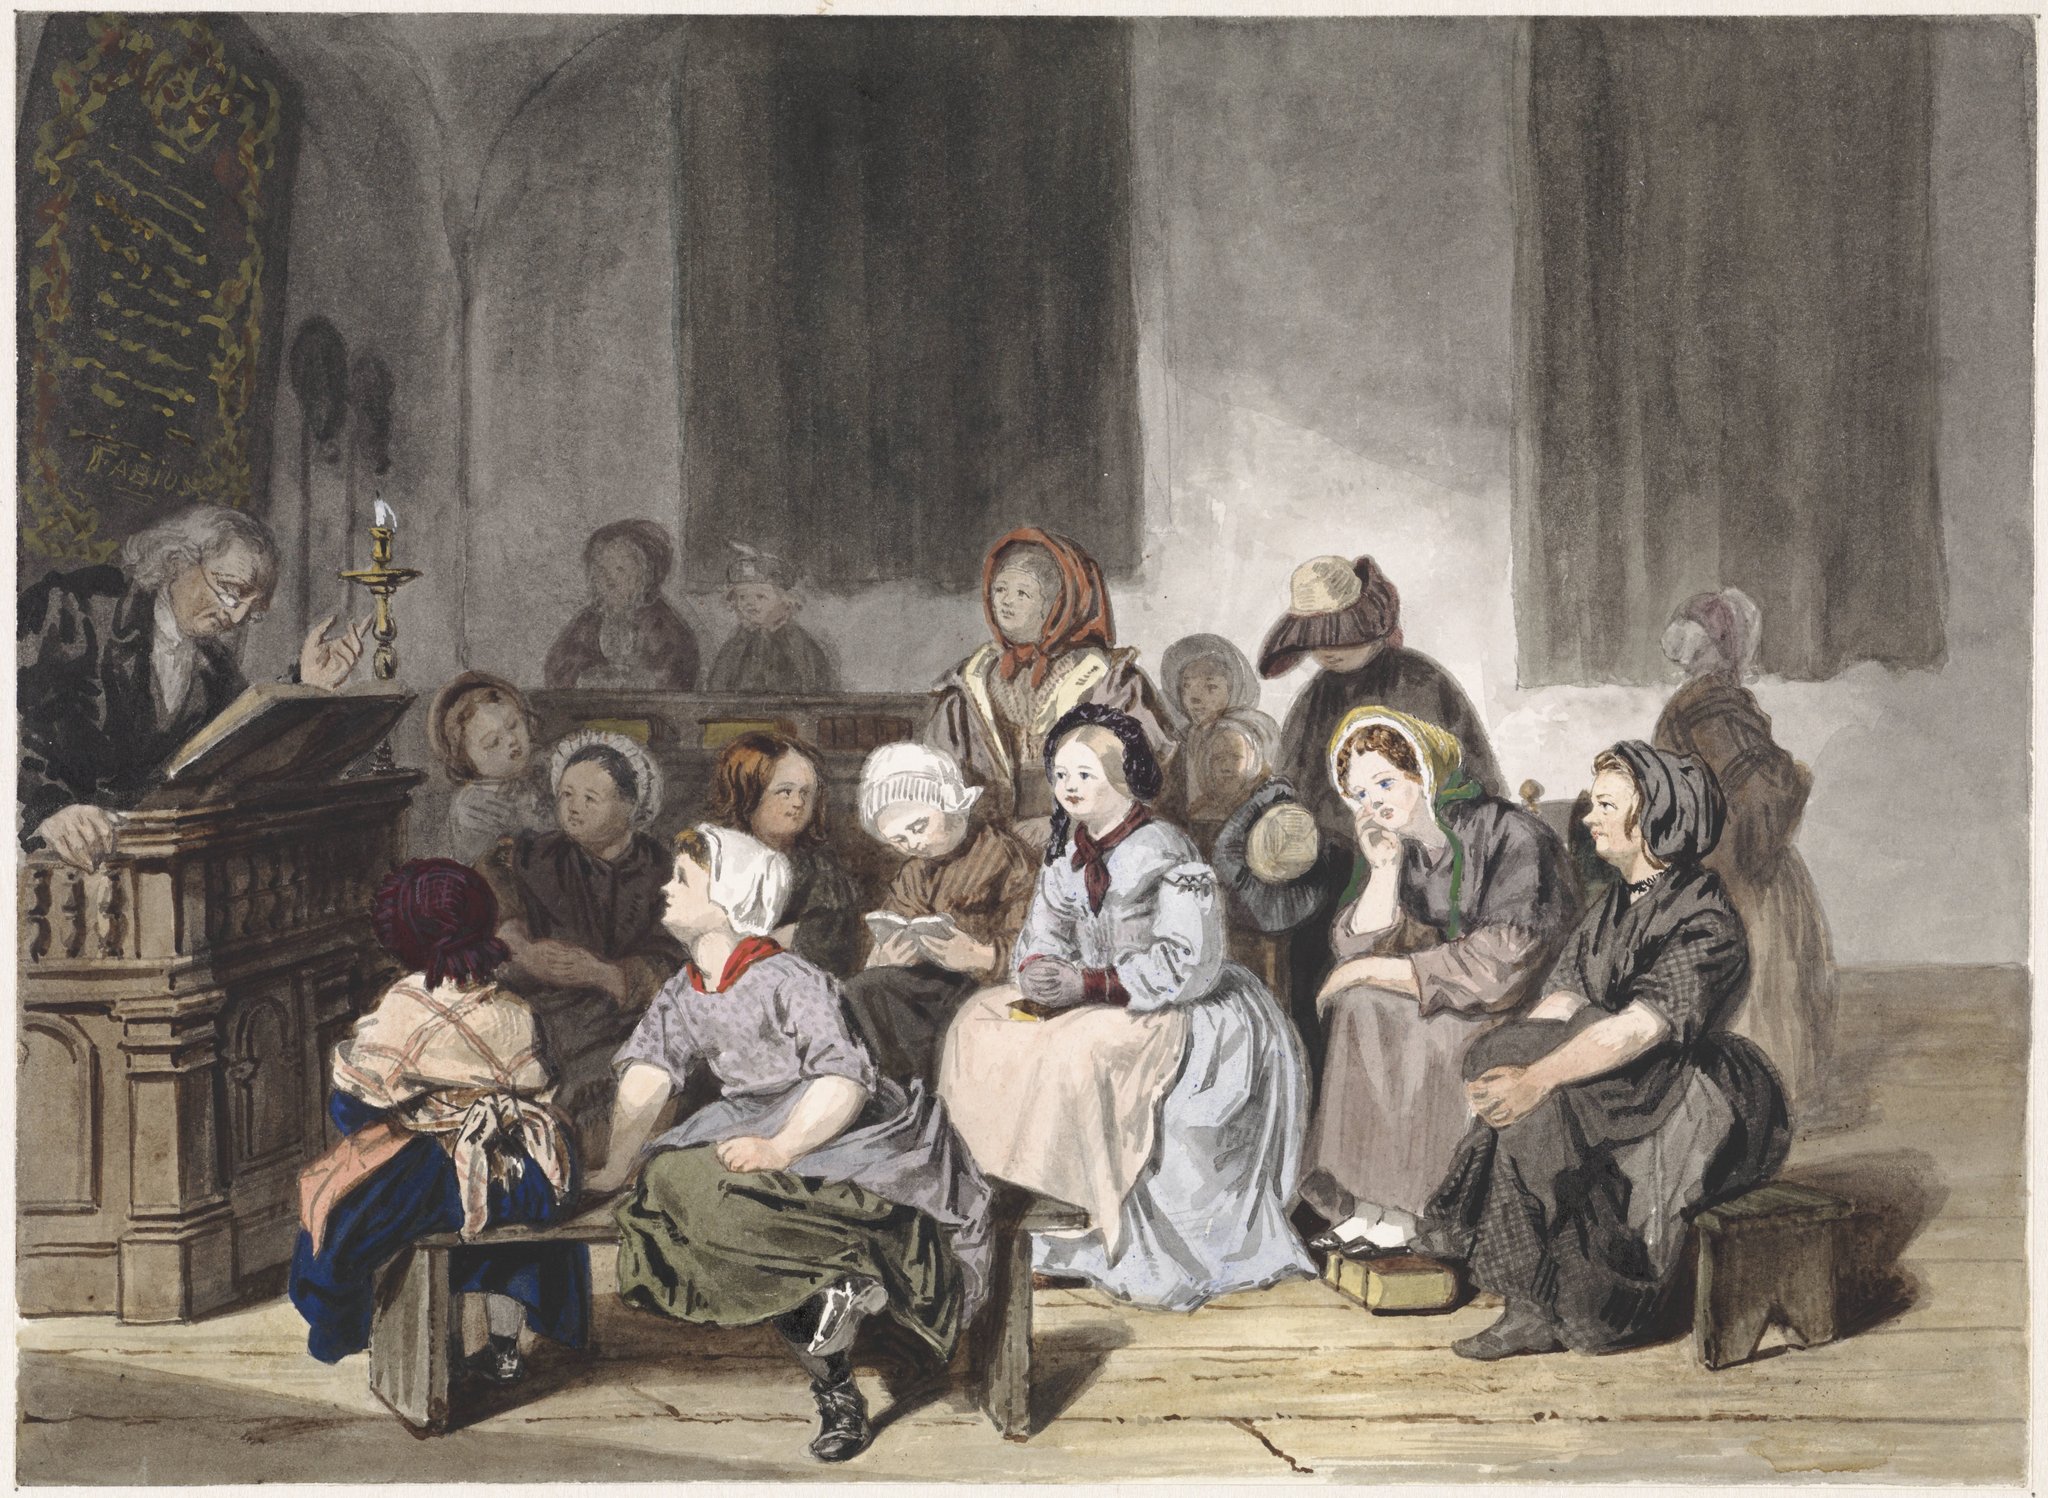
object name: watercolor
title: Kerkdienst met meisjes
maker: jan fabius czn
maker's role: draughtsman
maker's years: 1820-1889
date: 1830-1889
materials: chalk, paper, watercolor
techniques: brush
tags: the congregation, preaching (in general)